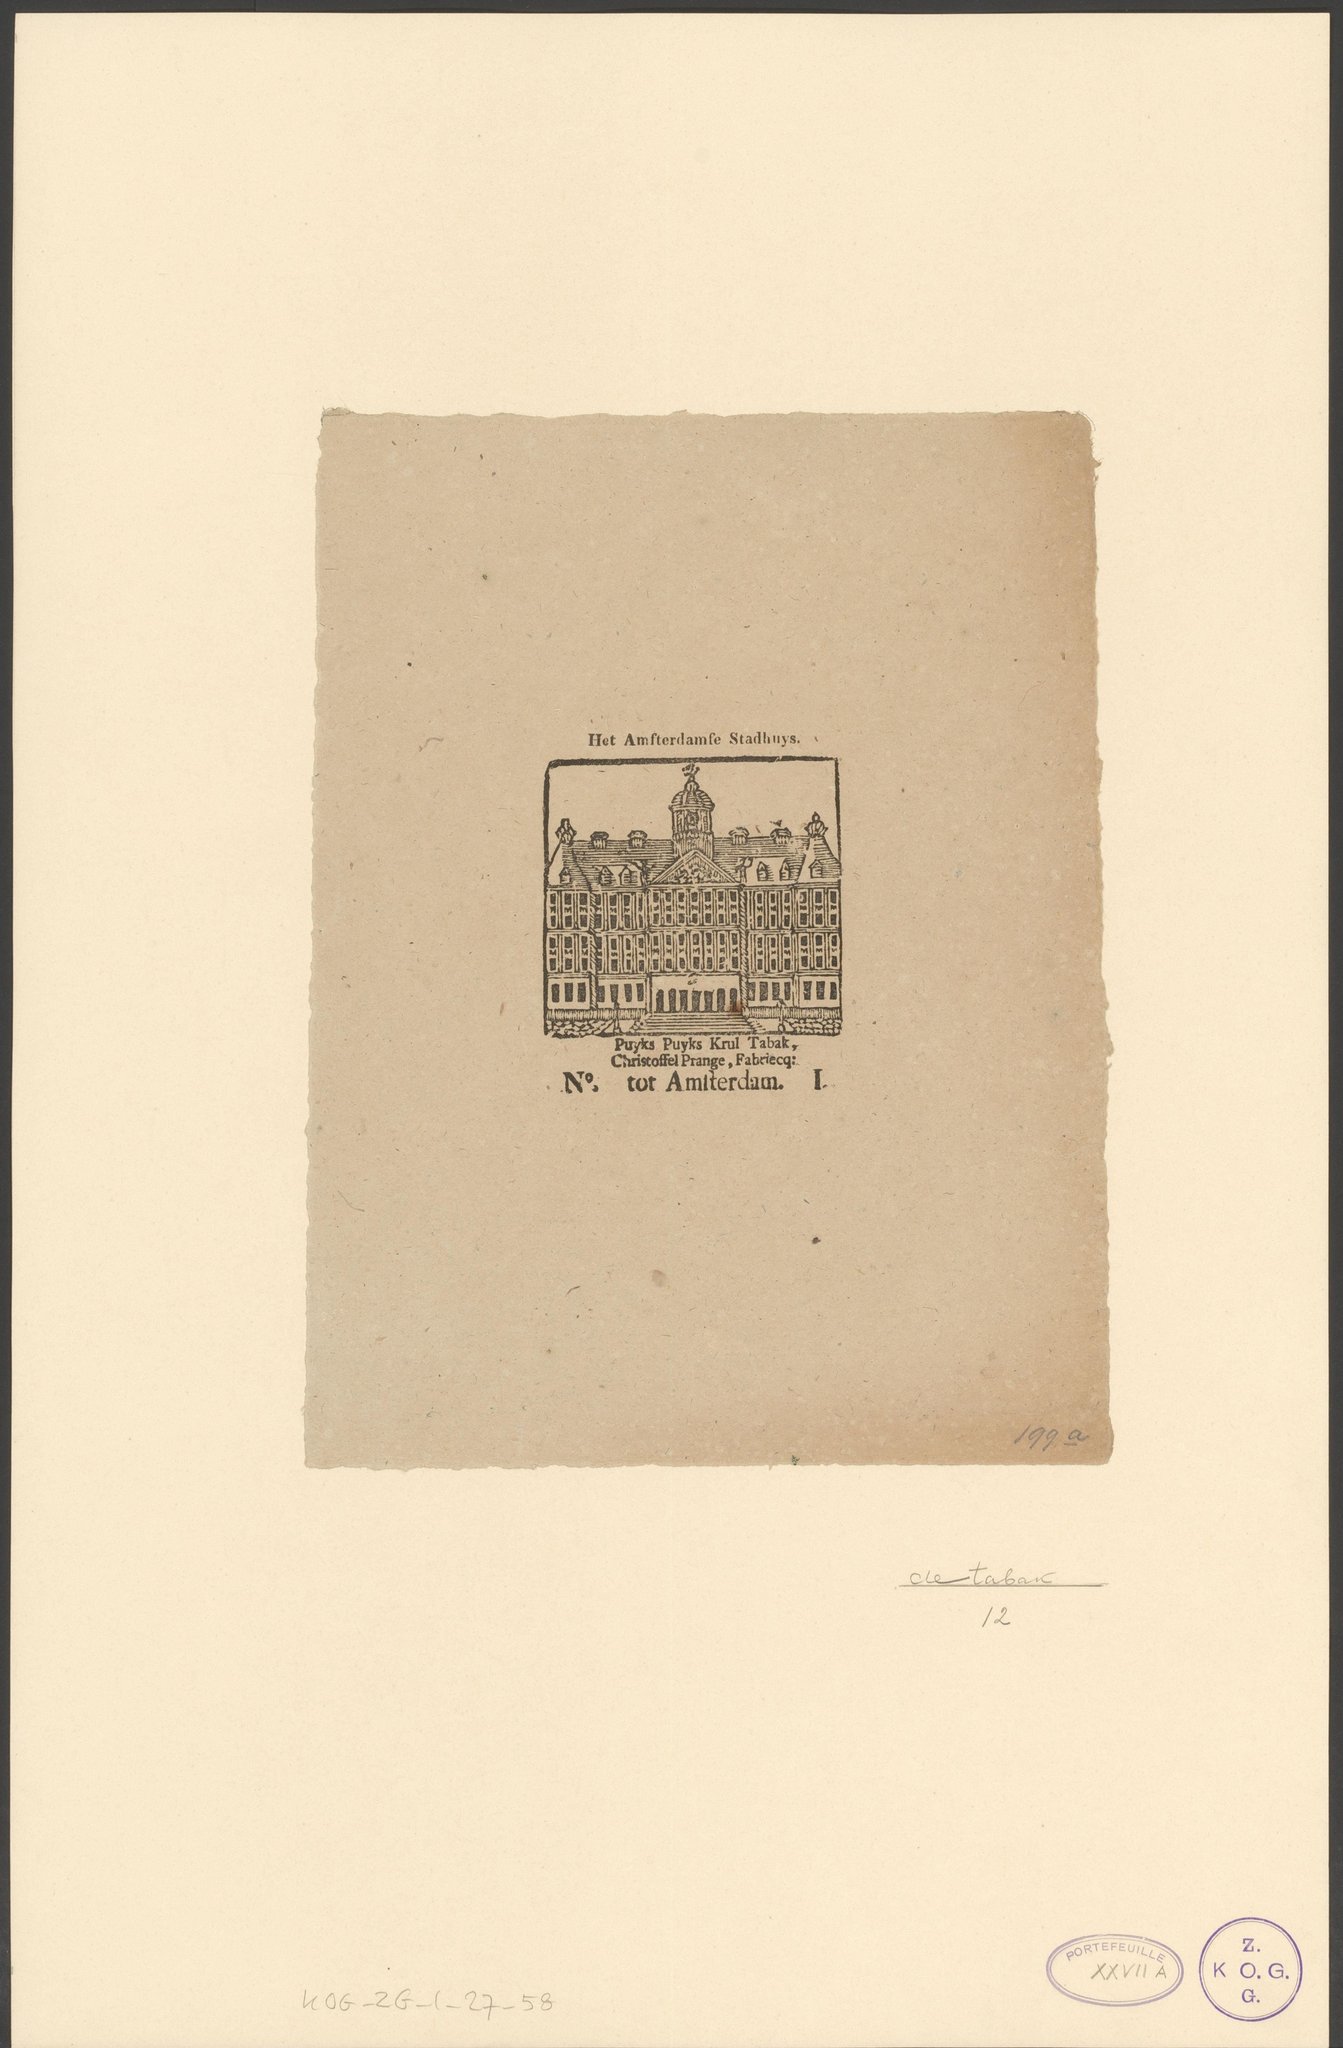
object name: print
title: Het Amsterdamse Stadhuys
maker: Anonymous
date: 1750-1790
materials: paper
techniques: letterpress printing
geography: netherlands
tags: amsterdam, townhall, tobacco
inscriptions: collector's mark: Lugt 1641, collector's mark